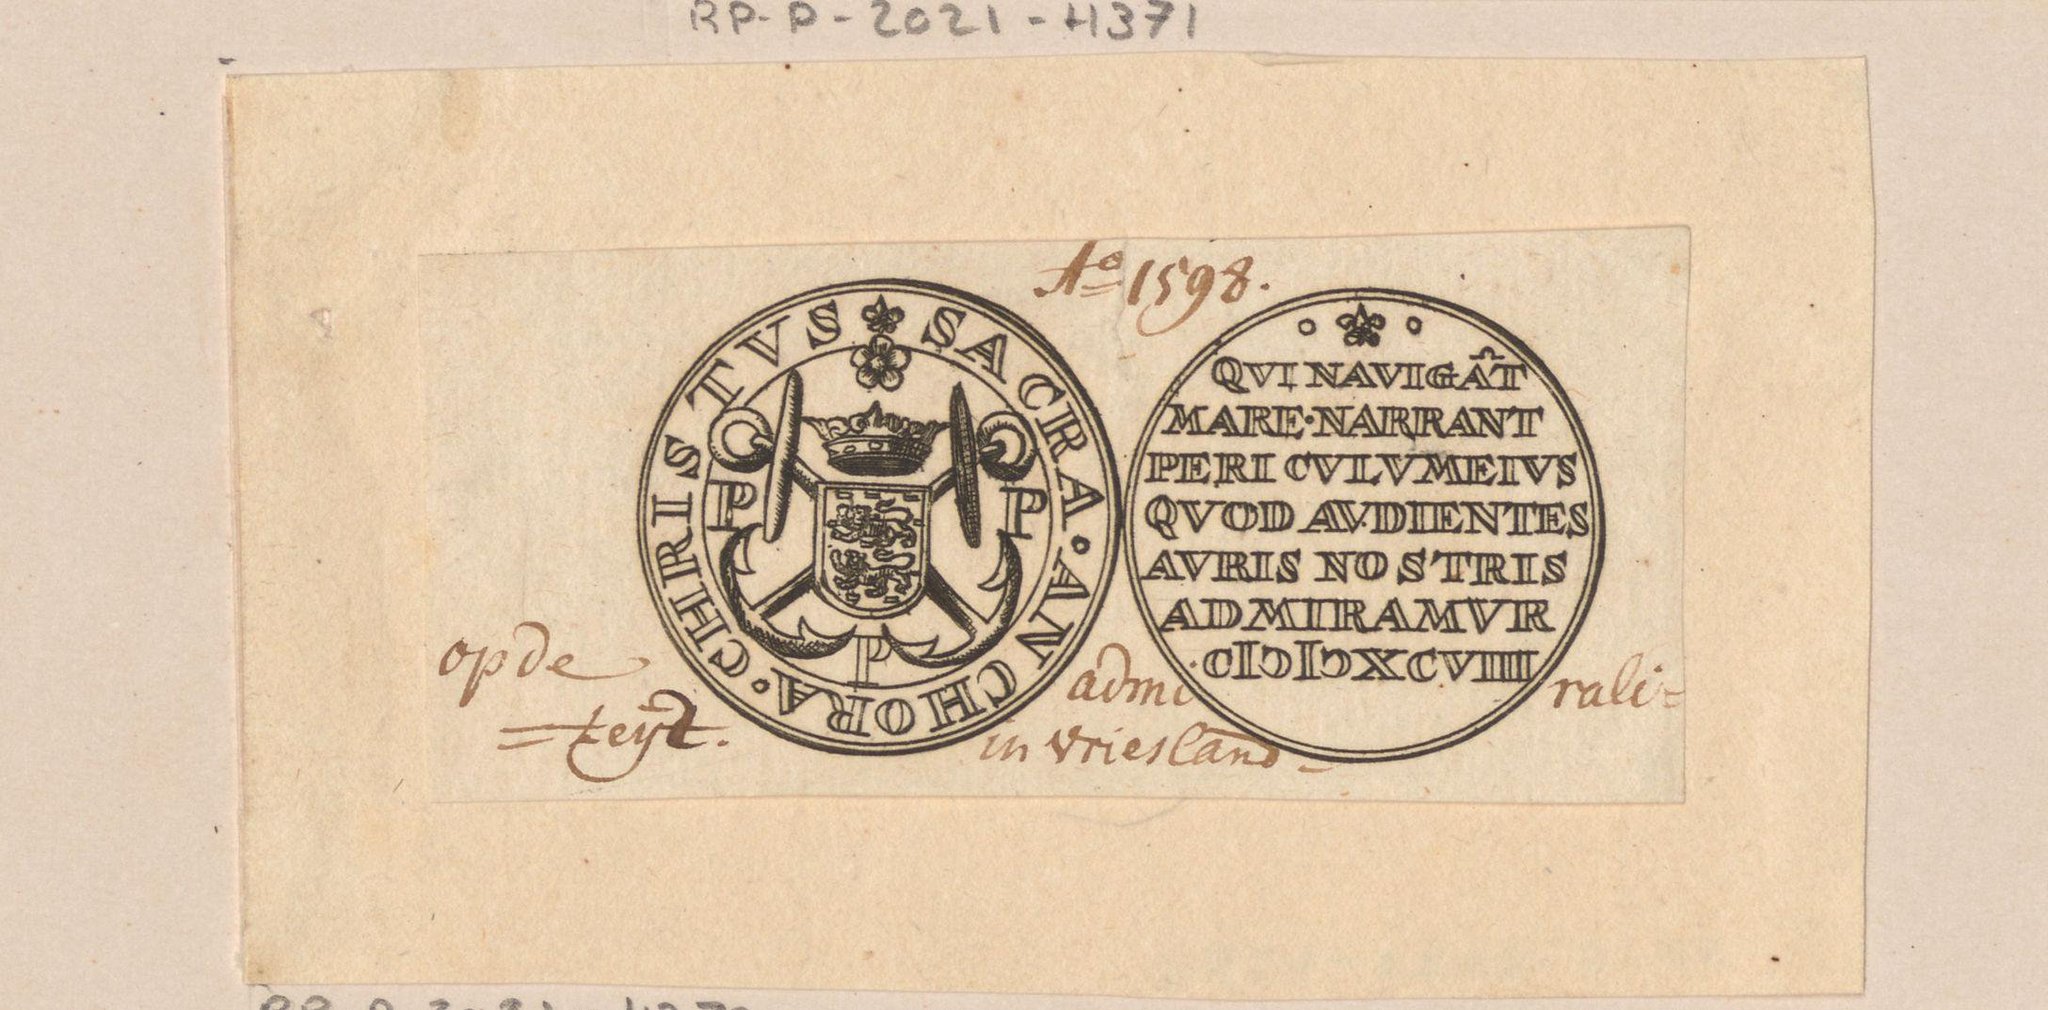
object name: book illustration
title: Penning met gekruiste ankers en het wapen van Friesland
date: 1690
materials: paper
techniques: etching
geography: amsterdam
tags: medal (considered as a piece of sculpture, regardless of its specific function), parts of ship's exterior: anchor, armorial bearing, heraldry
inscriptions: inscription: ‘A[nn]o 1598/ op de admiraliteyd in Vriesland.’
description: Prent gebruikt in: Bizot, Pierre. Supplement a l'histoire metallique de la republique de Hollande. Amsterdam: Pieter Mortier (I), 1690. Prent ook gebruikt in de Nederlandse editie van dit werk, uitgegeven in hetzelfde jaar bij dezelfde uitgever.